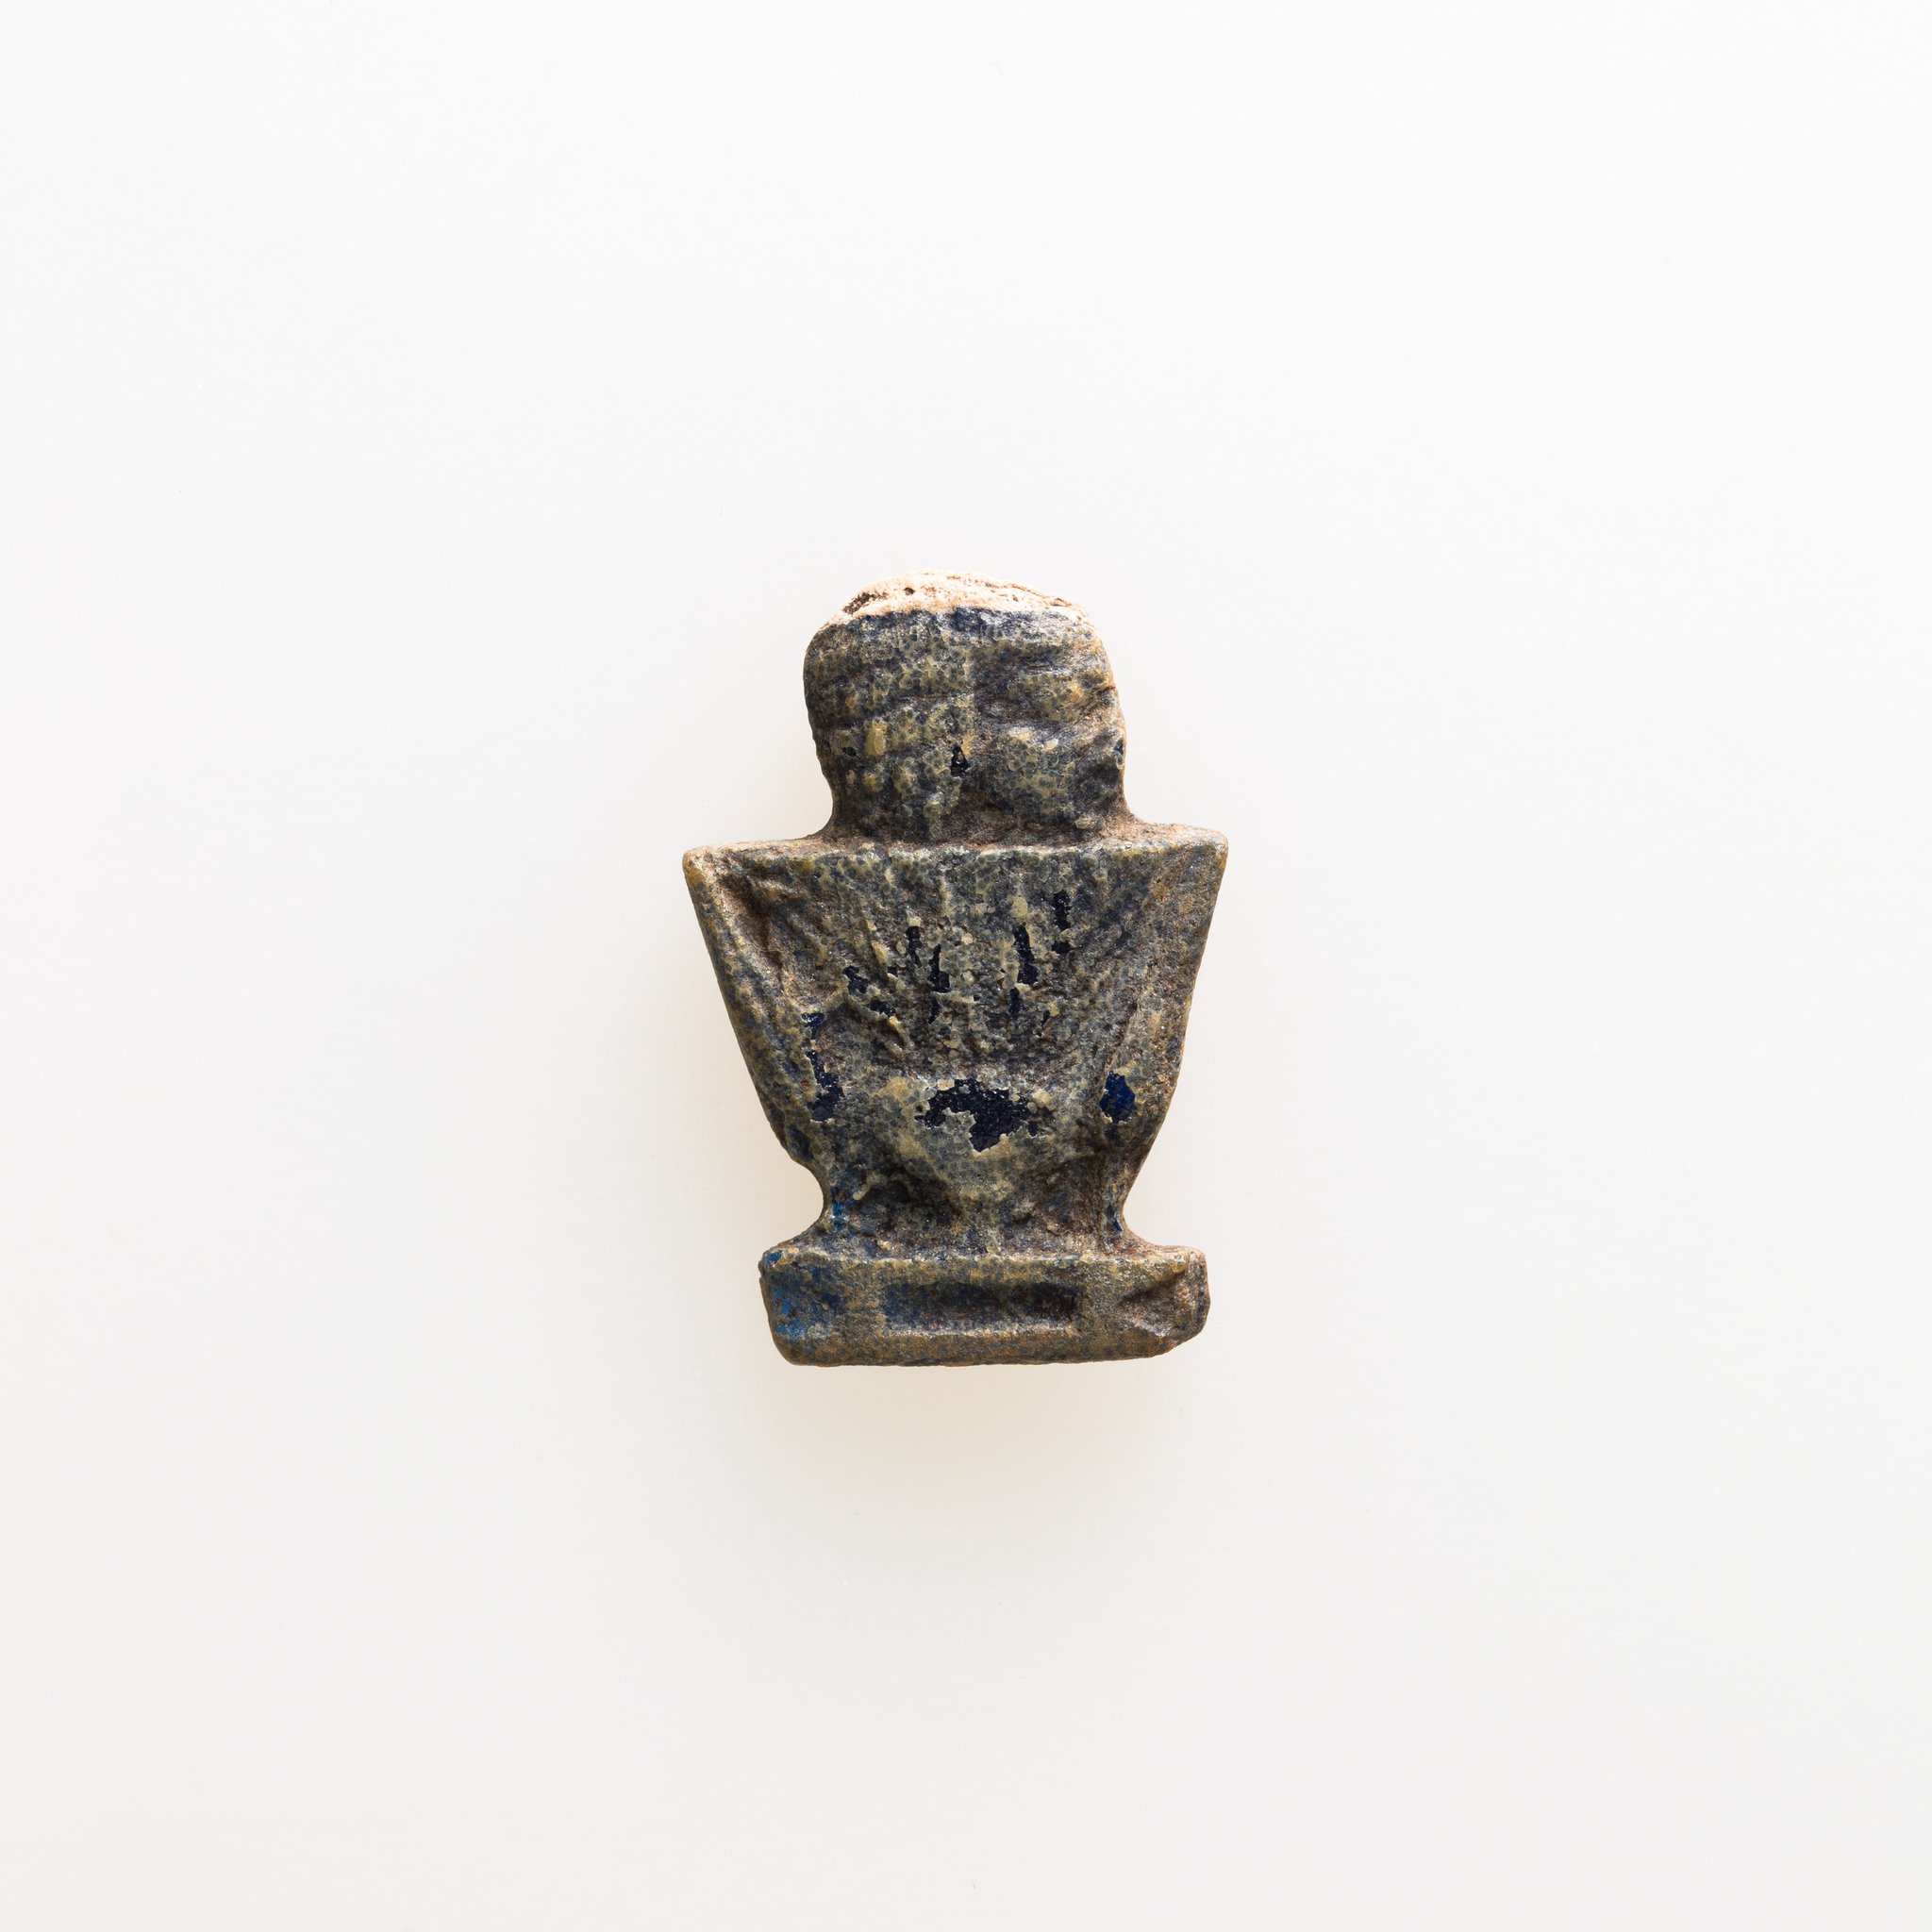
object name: amulet, human head, lotus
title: Amulet depicting human head emerging from lotus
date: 525-30 BCE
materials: glass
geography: egypt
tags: heads